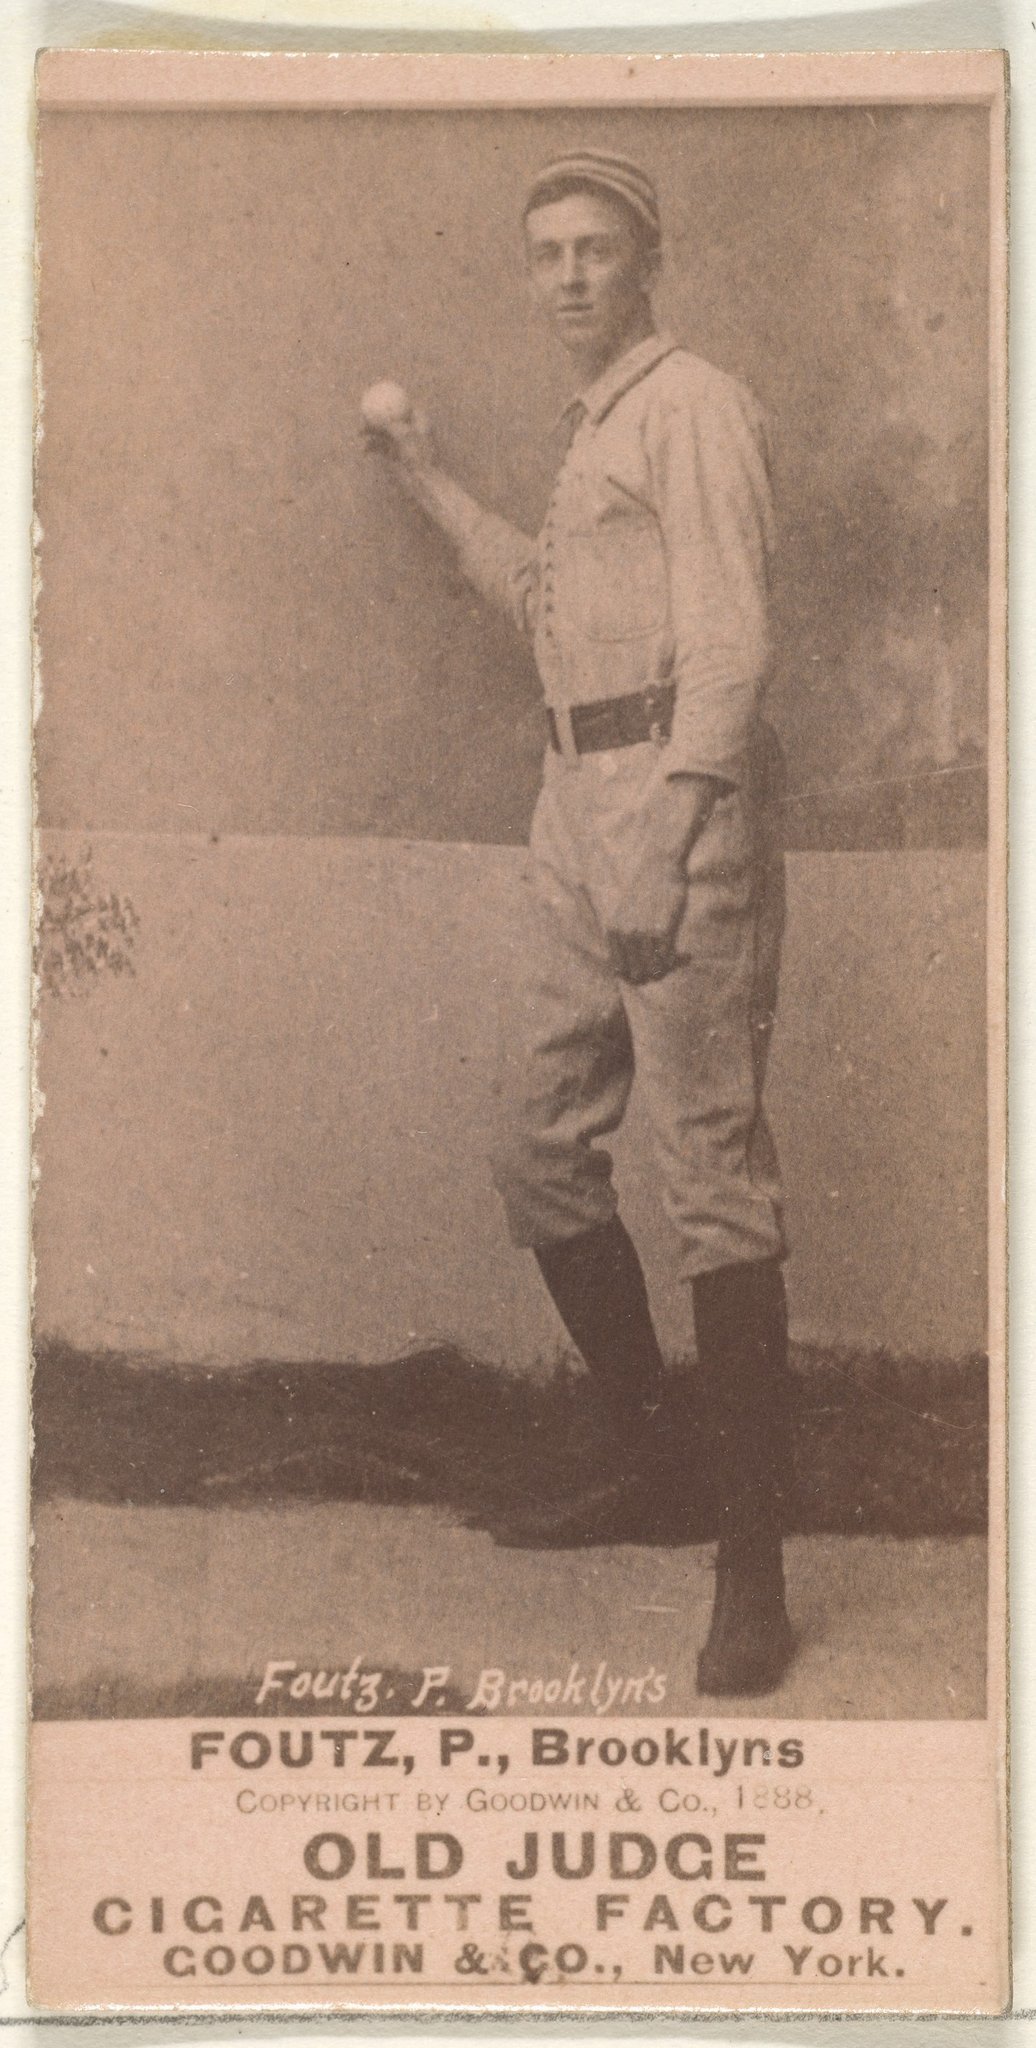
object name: baseball card, photograph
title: Foutz, Pitcher, Brooklyn Bridegrooms, from the Old Judge series (N172) for Old Judge Cigarettes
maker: goodwin & company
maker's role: publisher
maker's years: 1850-1950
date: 1888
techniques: albumen silver print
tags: men,portraits,baseball,athletes